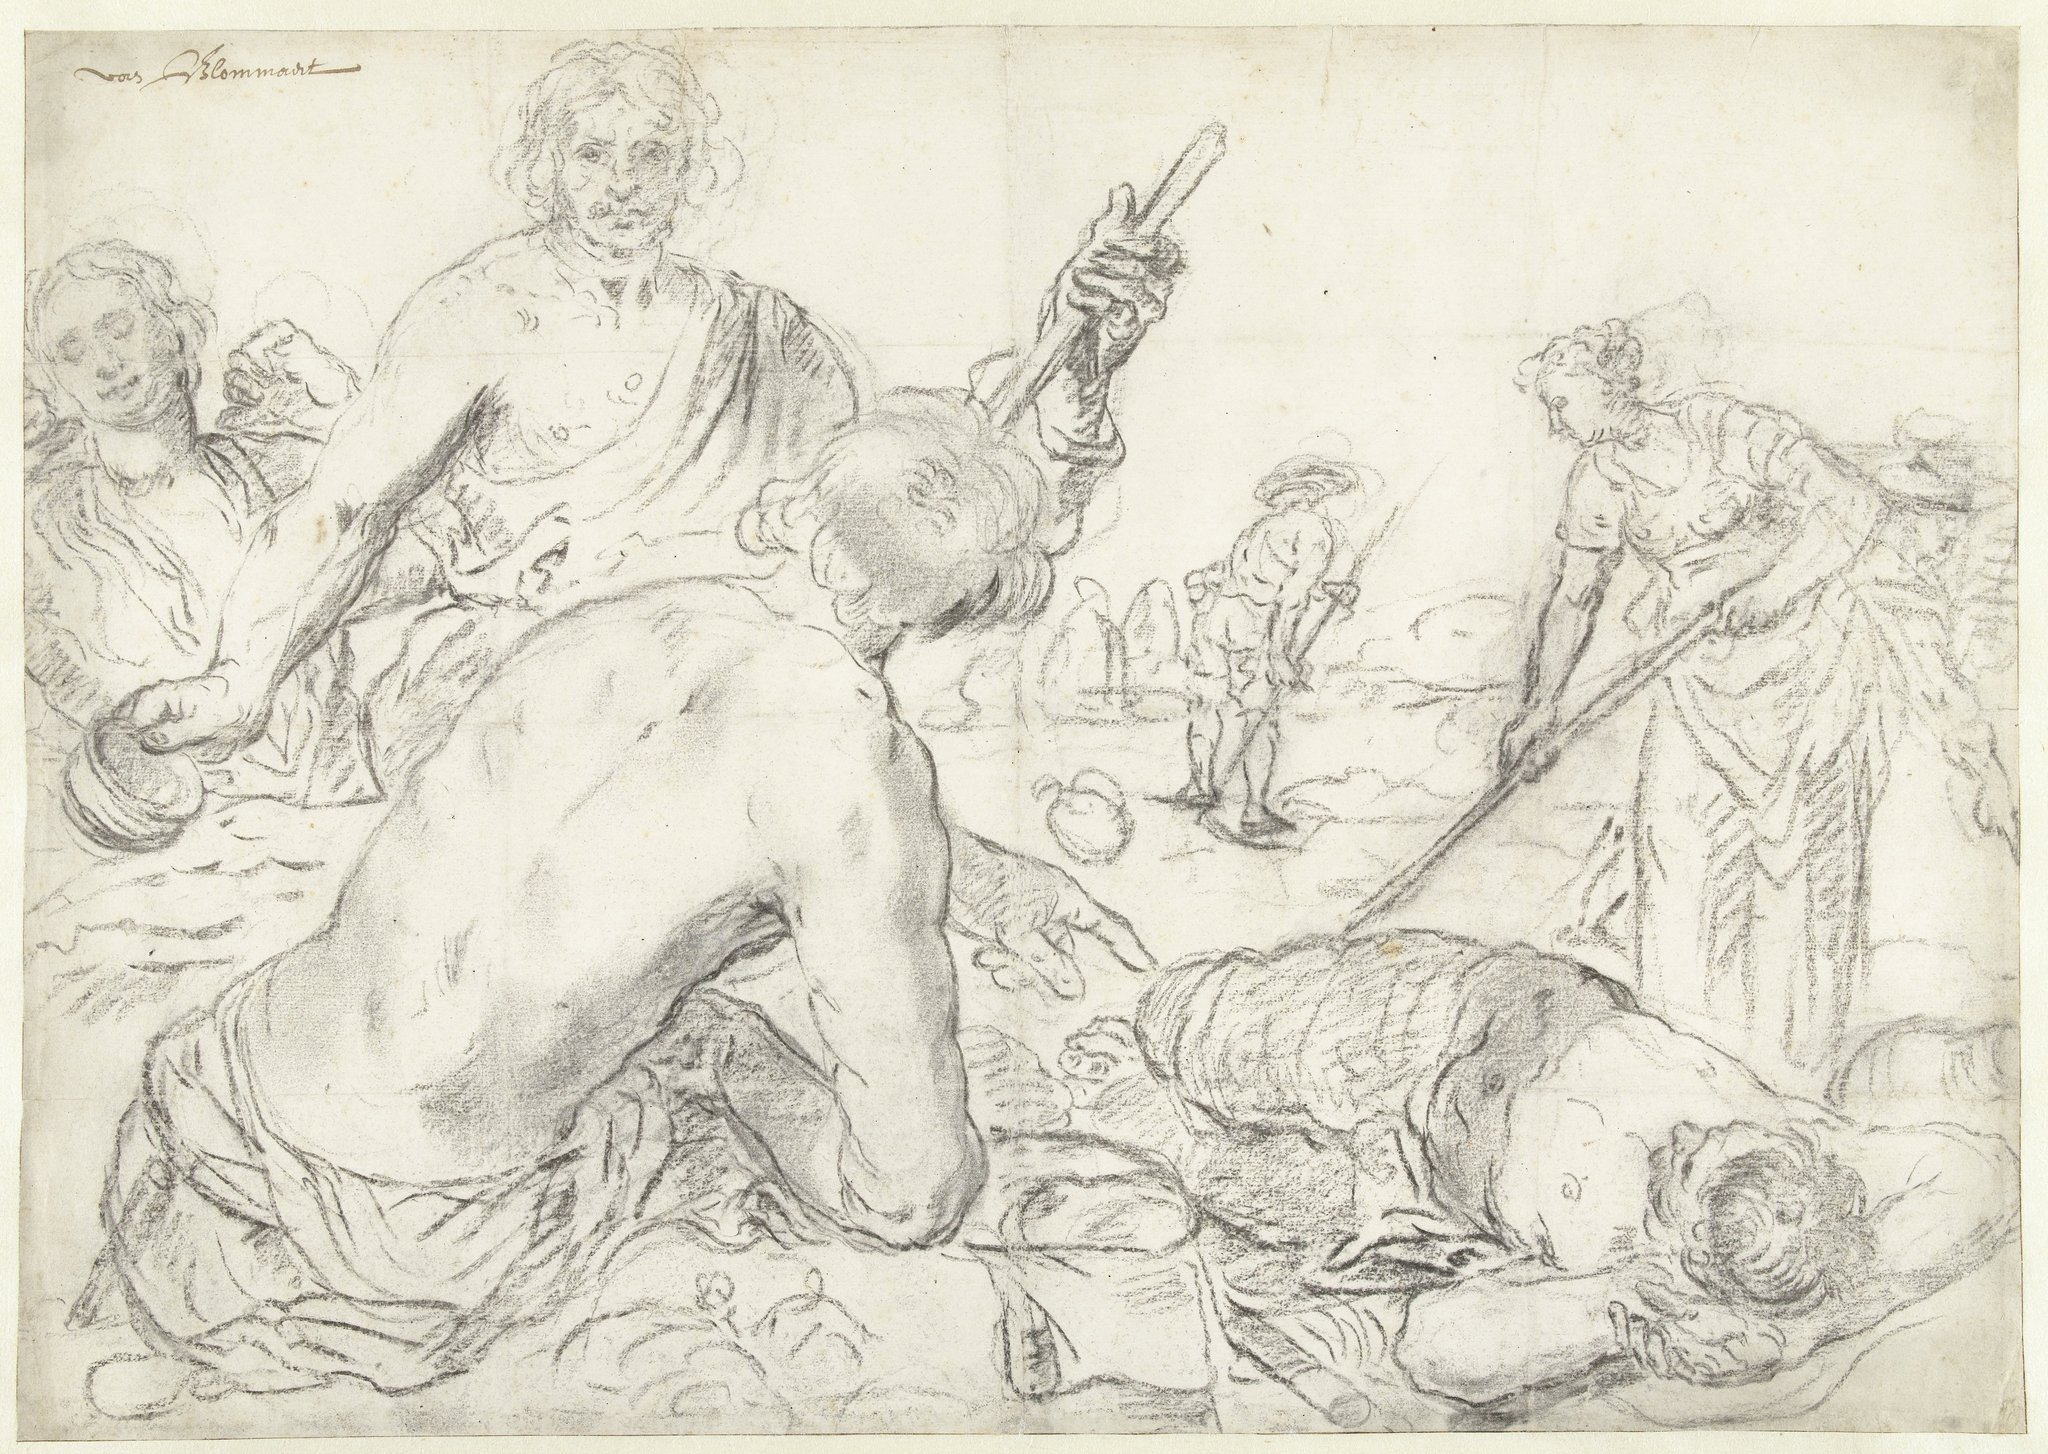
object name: drawing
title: Rustende maaiers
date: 1600-1699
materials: chalk, paper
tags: rest during harvest (eating, dancing, making love, etc.), reaping, picking, mowing ~ harvest